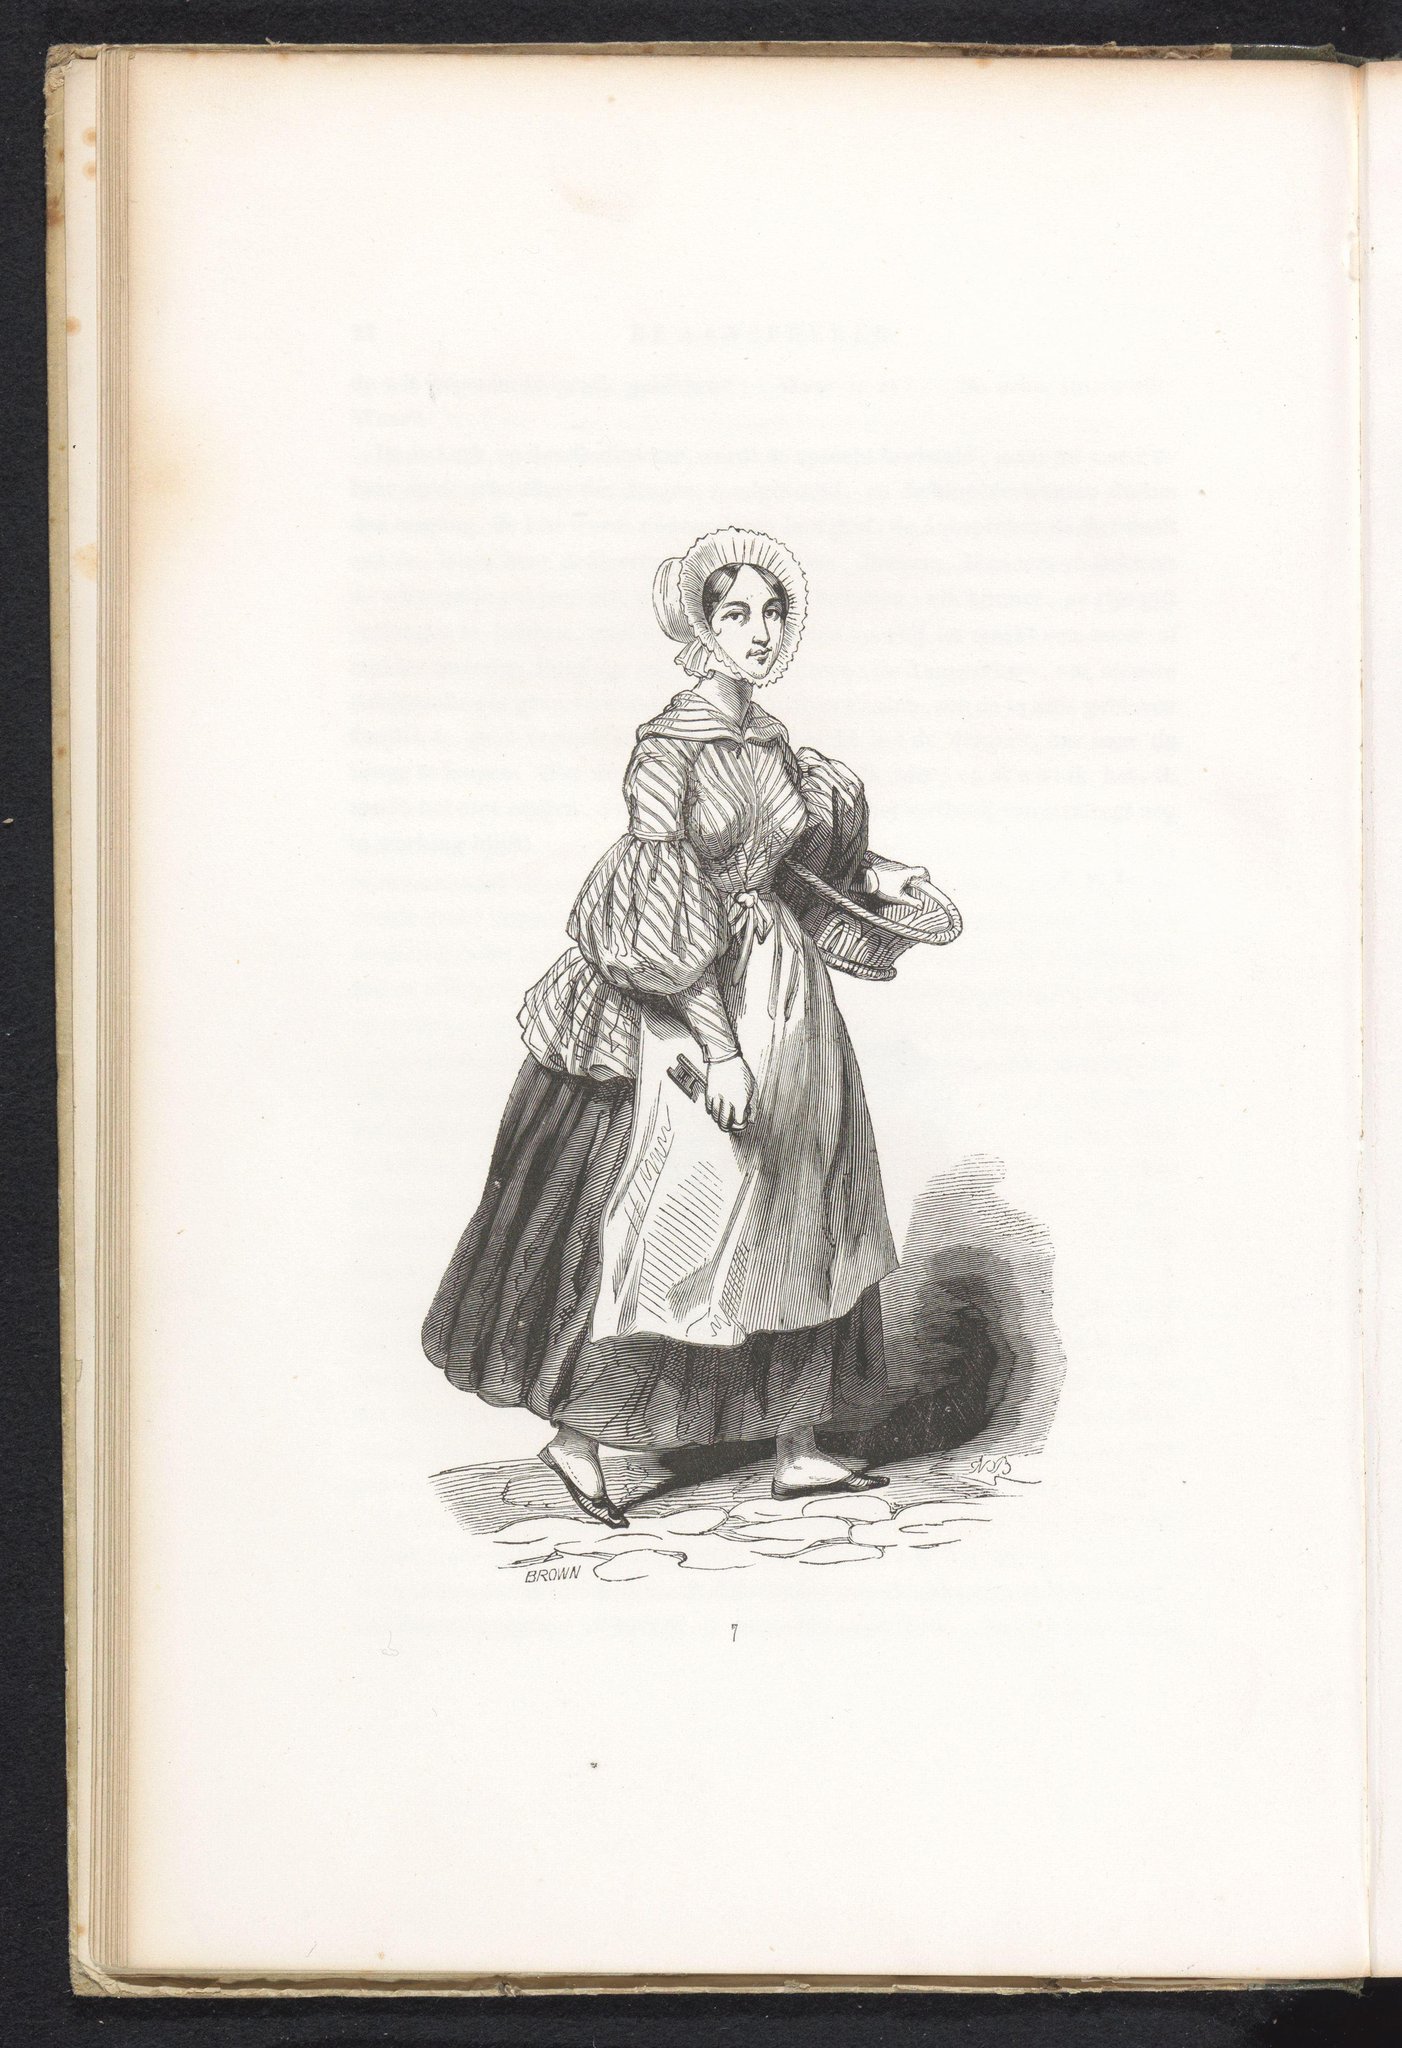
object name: book illustration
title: De Hollandse werkmeid, 1840-1841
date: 1841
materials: paper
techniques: letterpress printing, engraving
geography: netherlands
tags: professional clothes, maid ~ house personnel, netherlands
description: De Hollandse werkmeid, dienstbode. Staande jonge vrouw met mand onder de arm. Genummerd: 7. Illustratie in het boek 'De Nederlanden: karakterschetsen, kleederdrachten, houding en voorkomen van verschillende standen', een boek met karakterschetsen, beroepen en klederdrachten van Nederlandse volkstypen uit 1841.